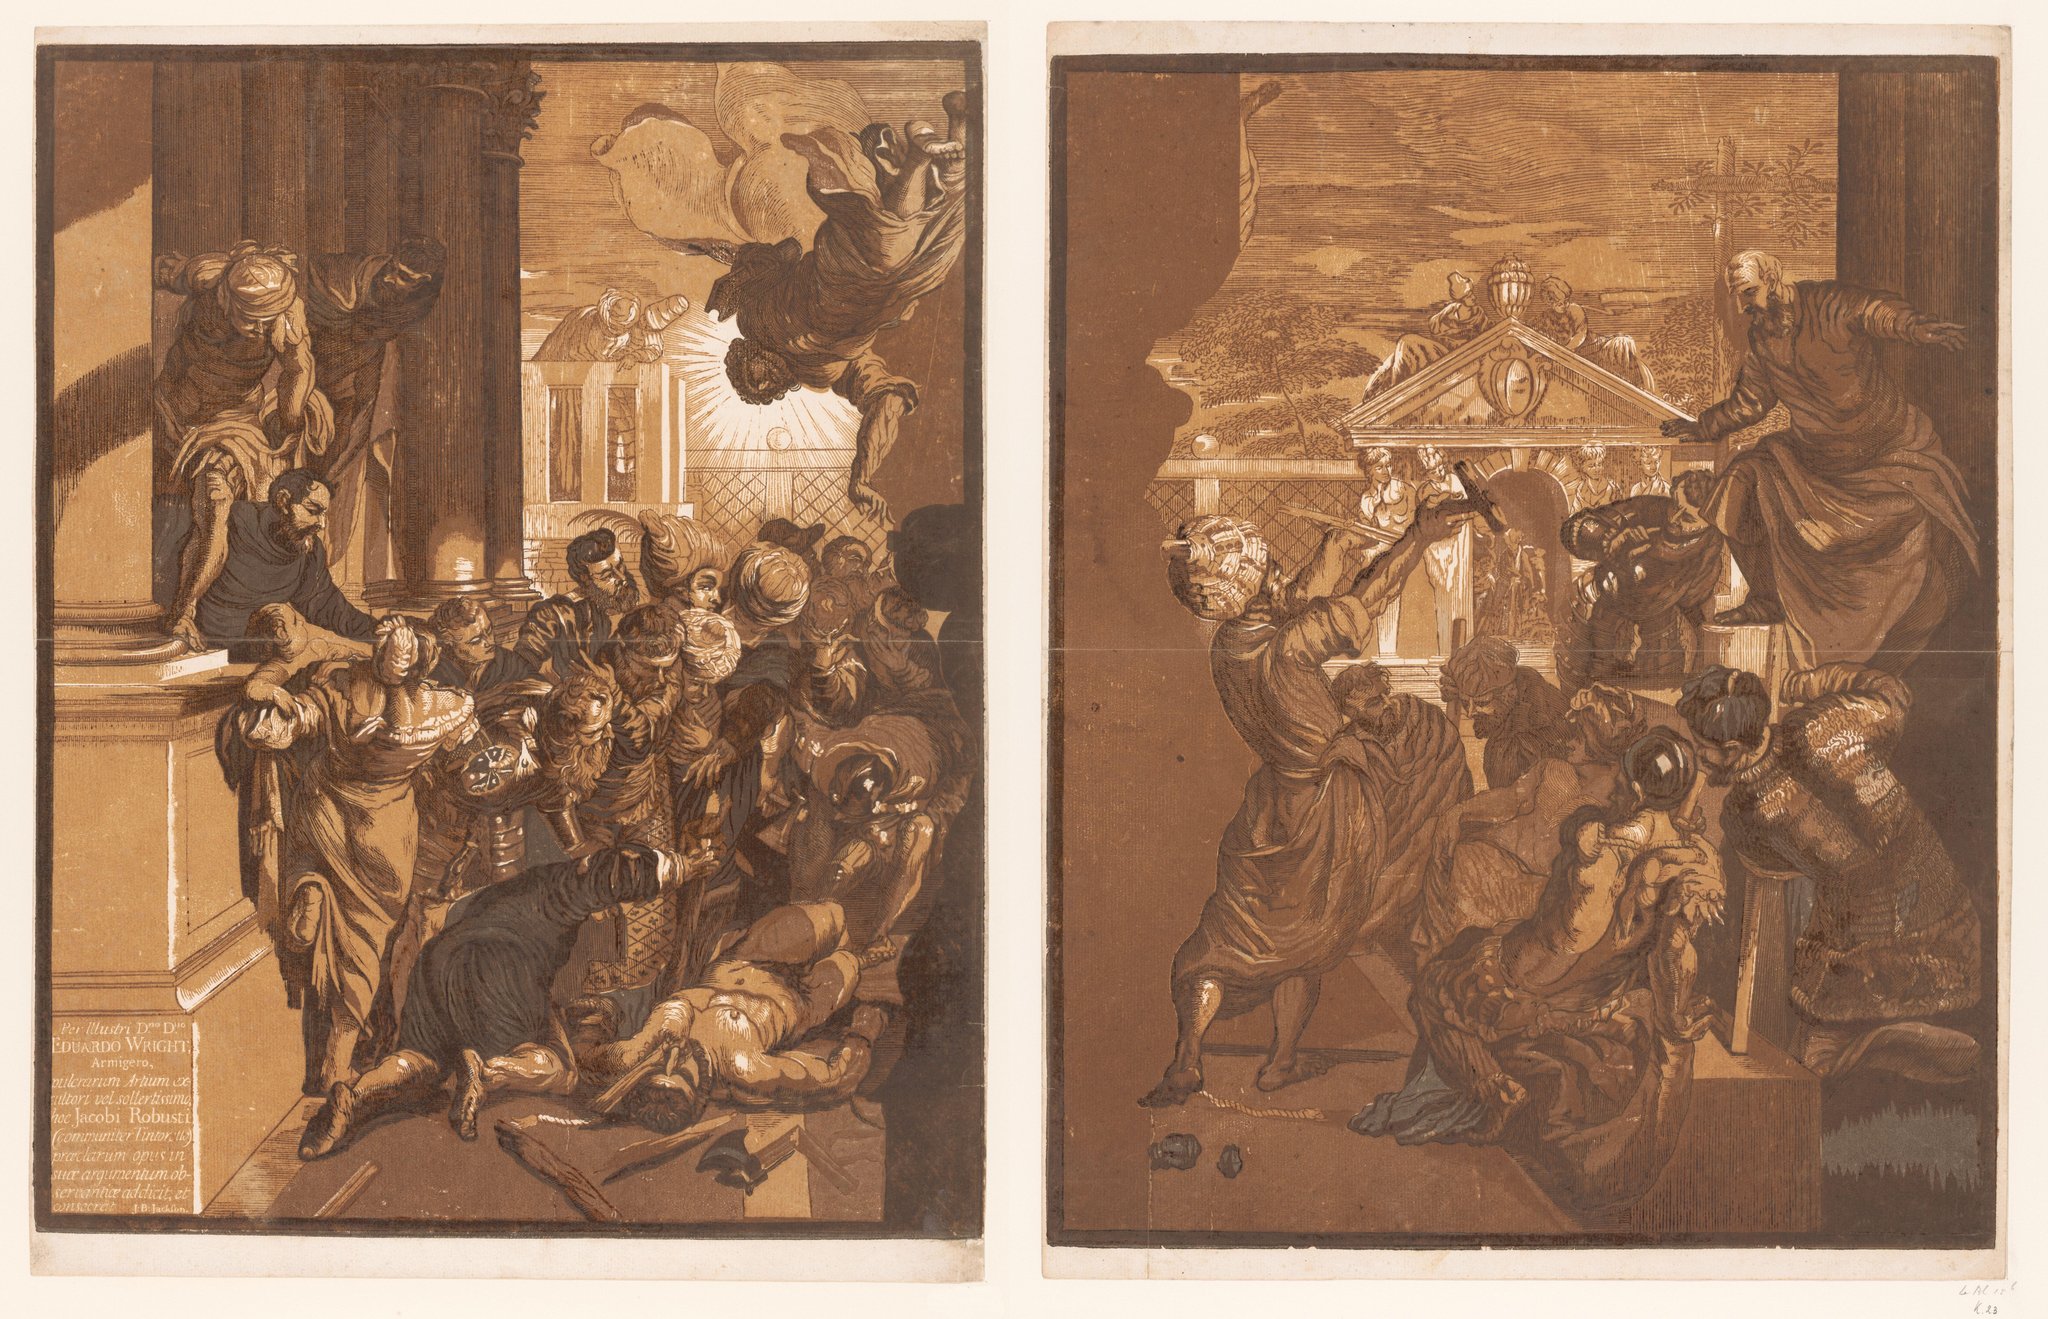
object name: print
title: Opera selectiora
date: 1745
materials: paper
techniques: woodcut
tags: slavery; serfs and enslaved persons, st. mark rescues a slave from martyrdom by coming down from heaven; the instruments of torture break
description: Prent maakt deel uit van een ongenummerde serie van 24 prenten. Dit object is omwille van een betere presentatie virtueel samengevoegd, maar bestaat fysiek uit losse onderdelen.